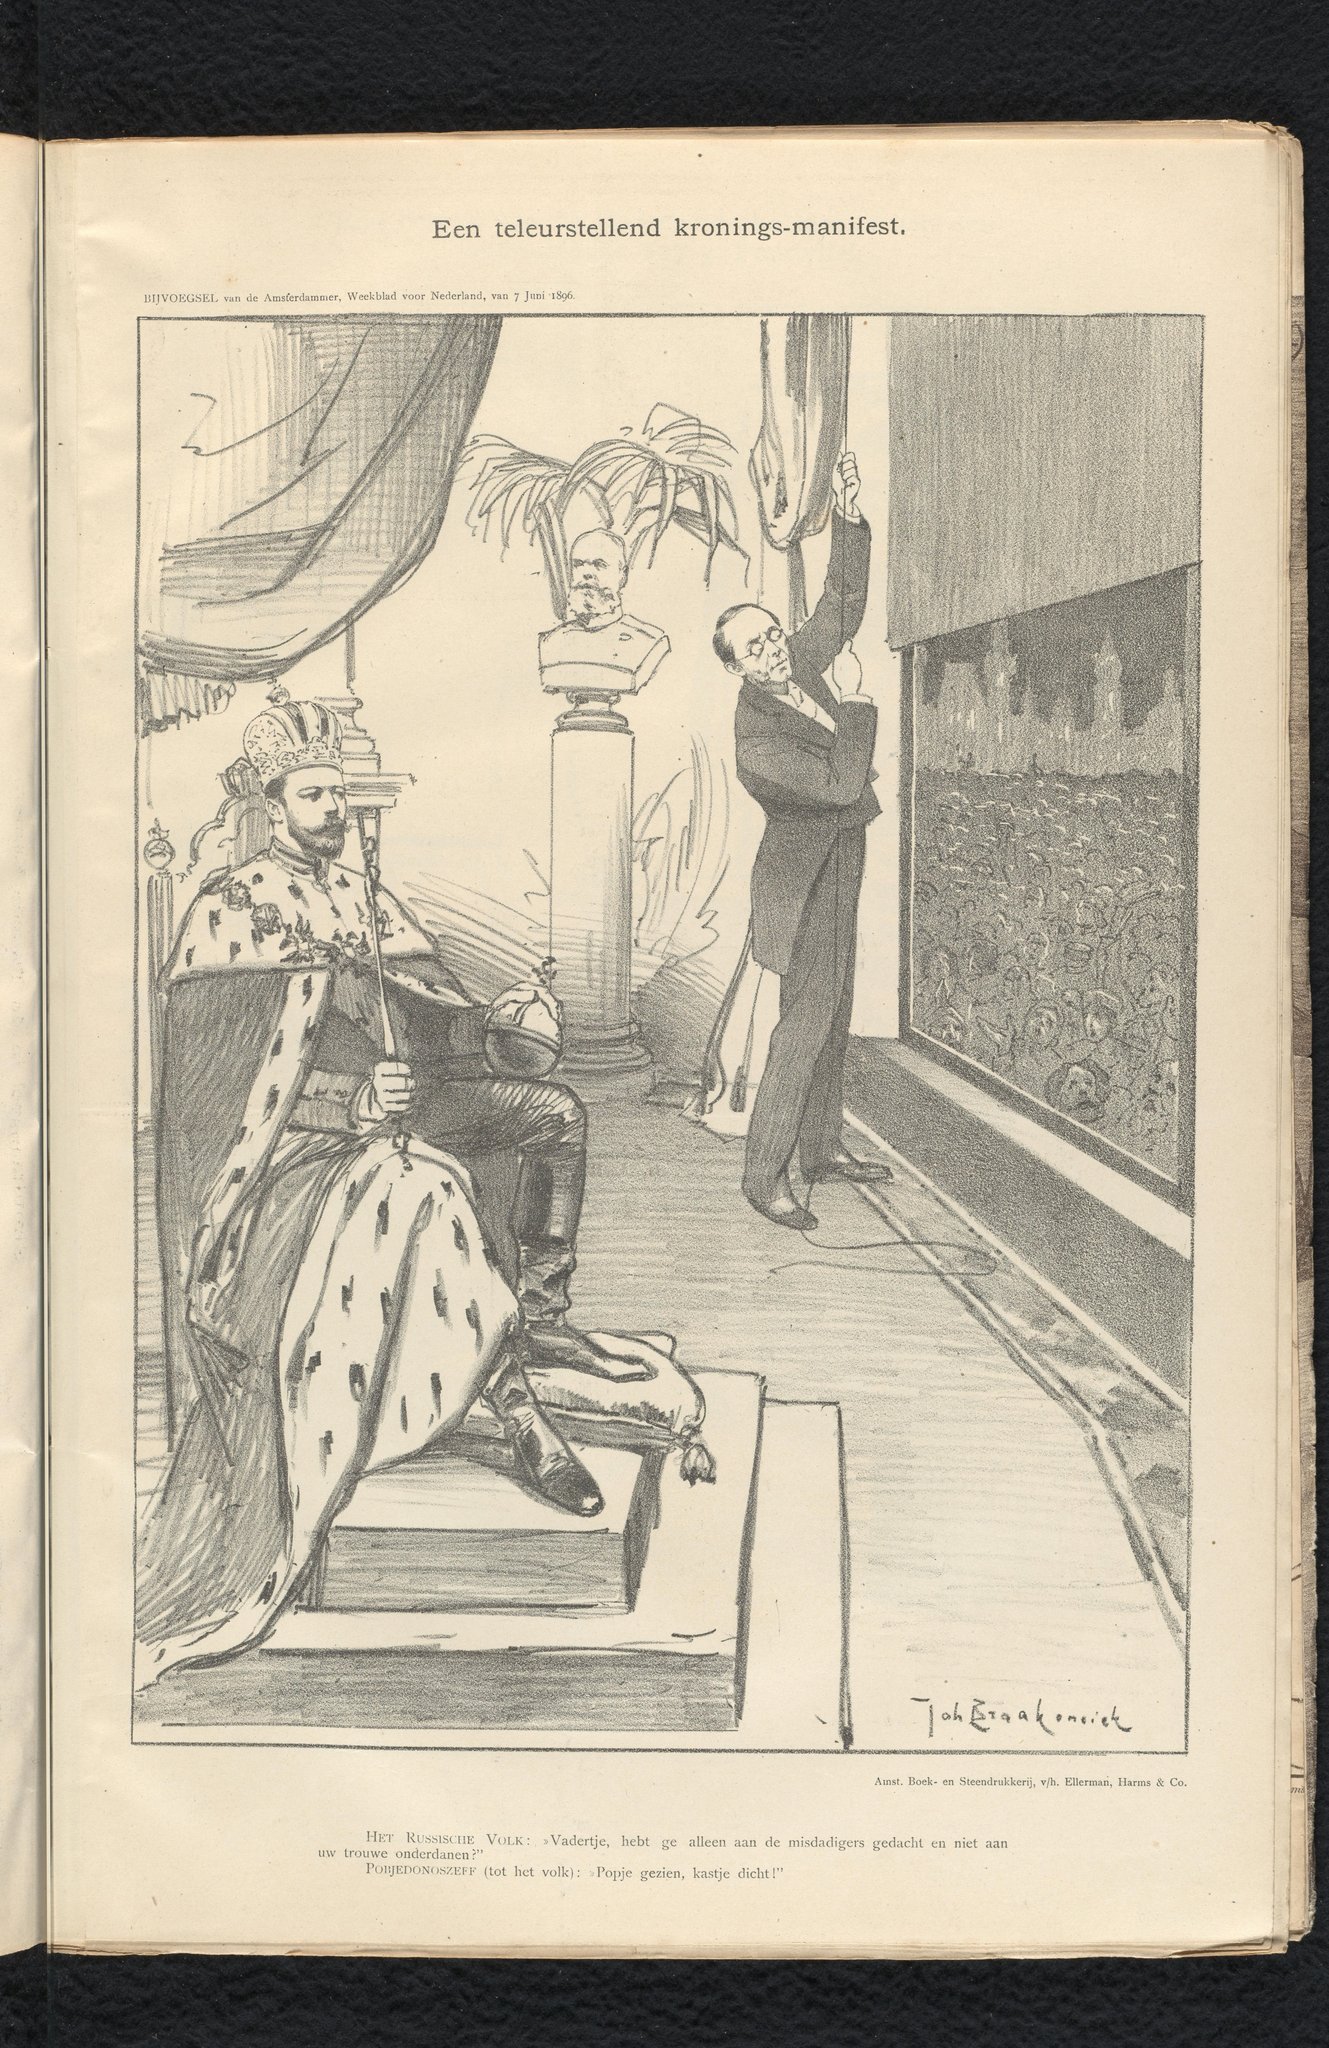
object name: cartoon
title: Een teleurstellend kronings-manifest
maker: johan braakensiek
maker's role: draughtsman, print maker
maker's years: 1858-1940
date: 1896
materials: paper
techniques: lithograph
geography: netherlands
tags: throne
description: Tsaar Nicolaas II gezeten op de troon aan het volk getoond door zijn adviseur Konstantin Pobedonostsev.